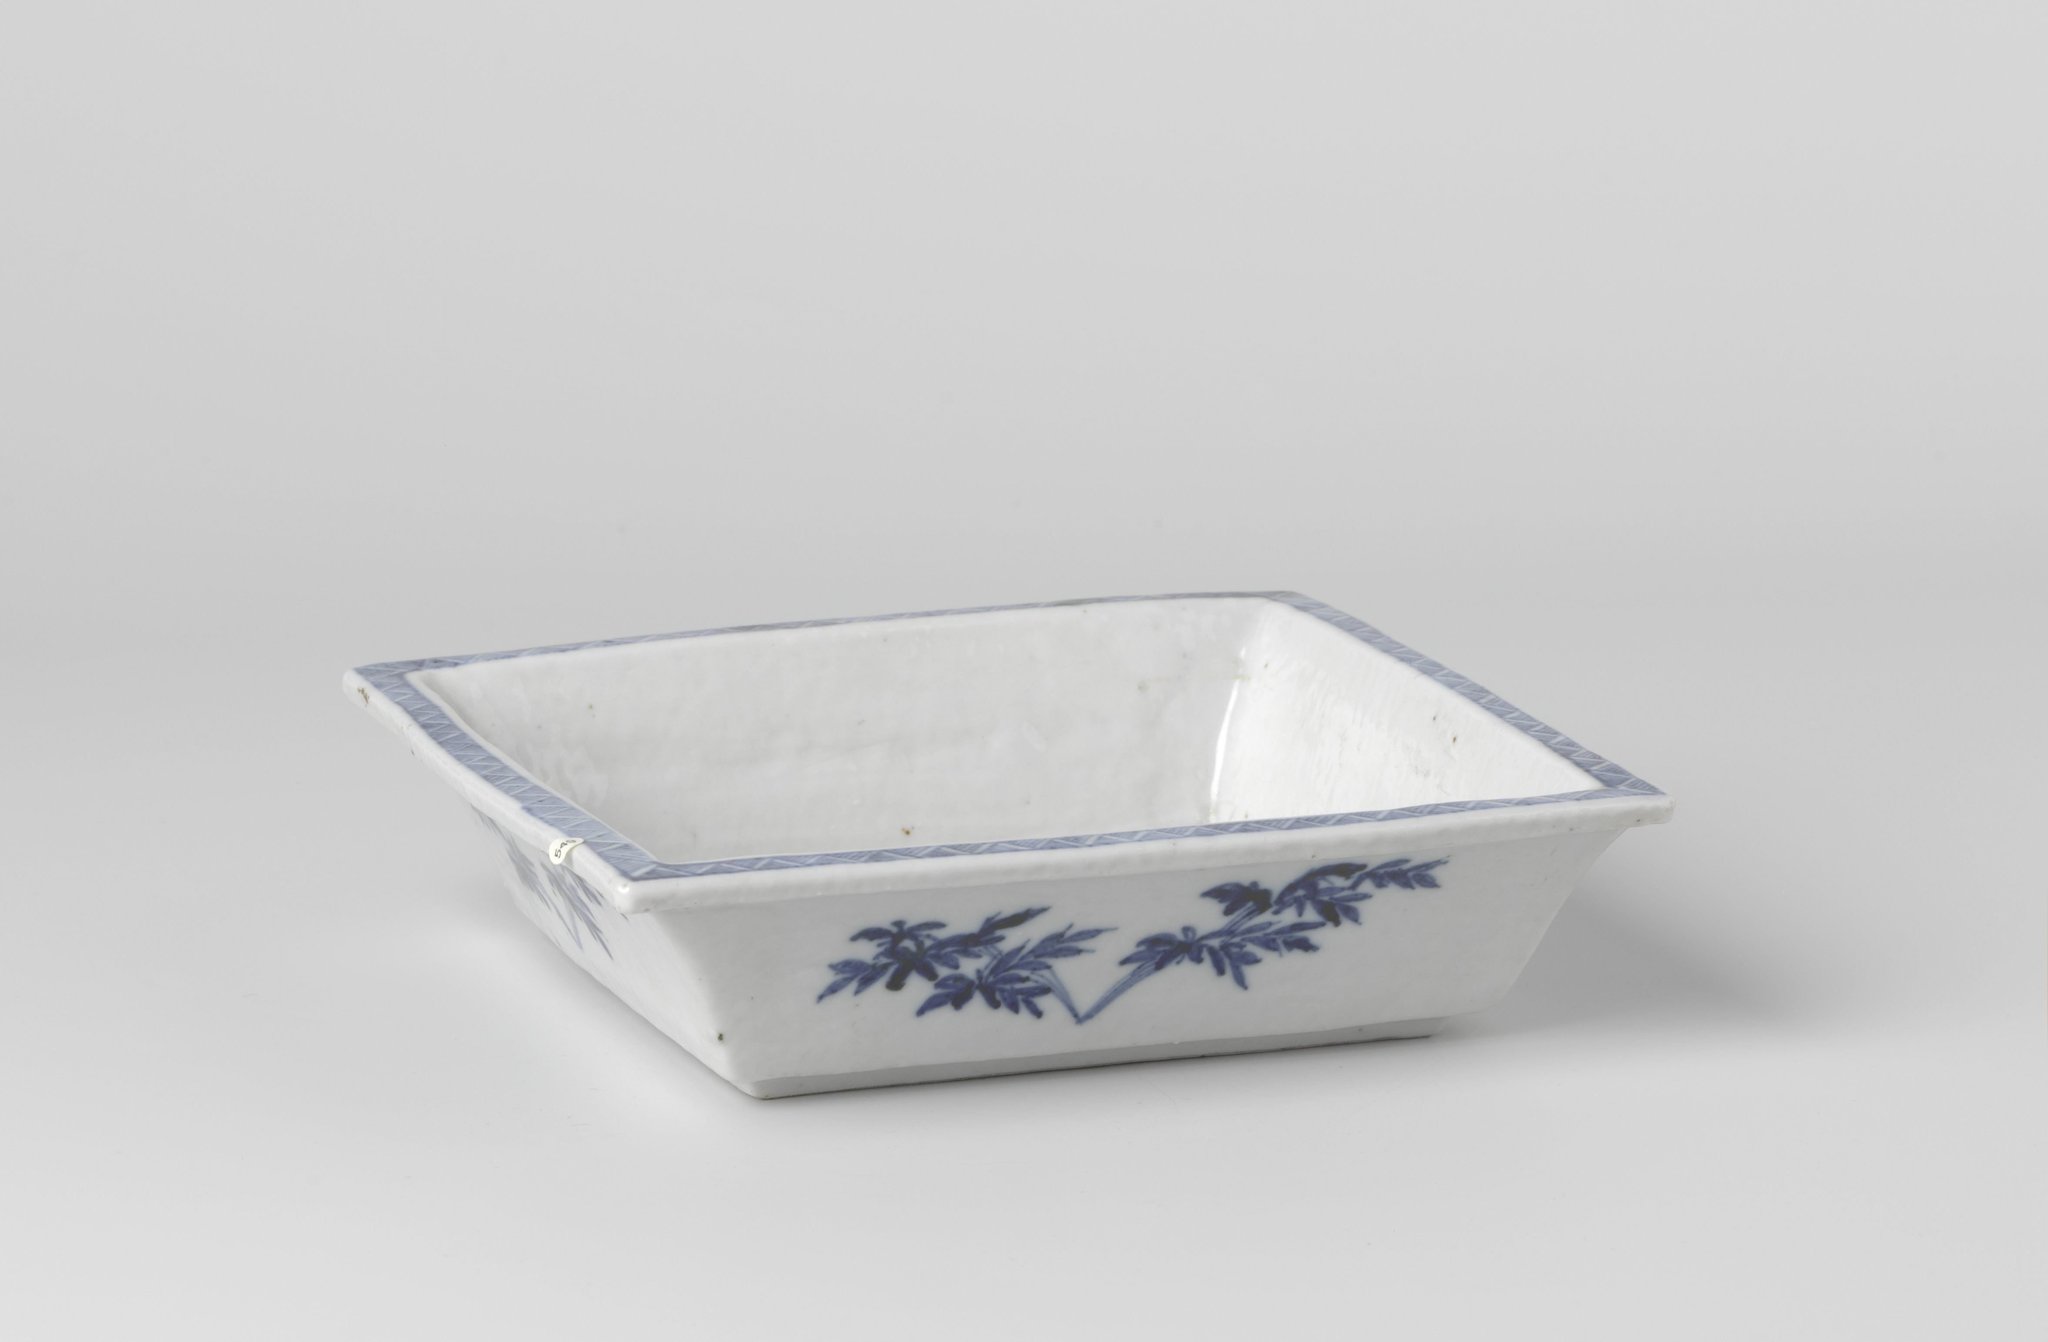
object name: jardinière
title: Square jardinière and stand with river landschapes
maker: Anonymous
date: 1775-1799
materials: cobalt, glaze, paint, porcelain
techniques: firing, turning, vitrification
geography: china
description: Vierkante jardinière met standaard, beide op voetring, met spreidende zijden en platte rand. Gedecoreerd in onderglazuur blauw met een rivierlandschap, met op de oevers huizen en bomen. De wanden van de standaard zijn beschilderd met bamboe.